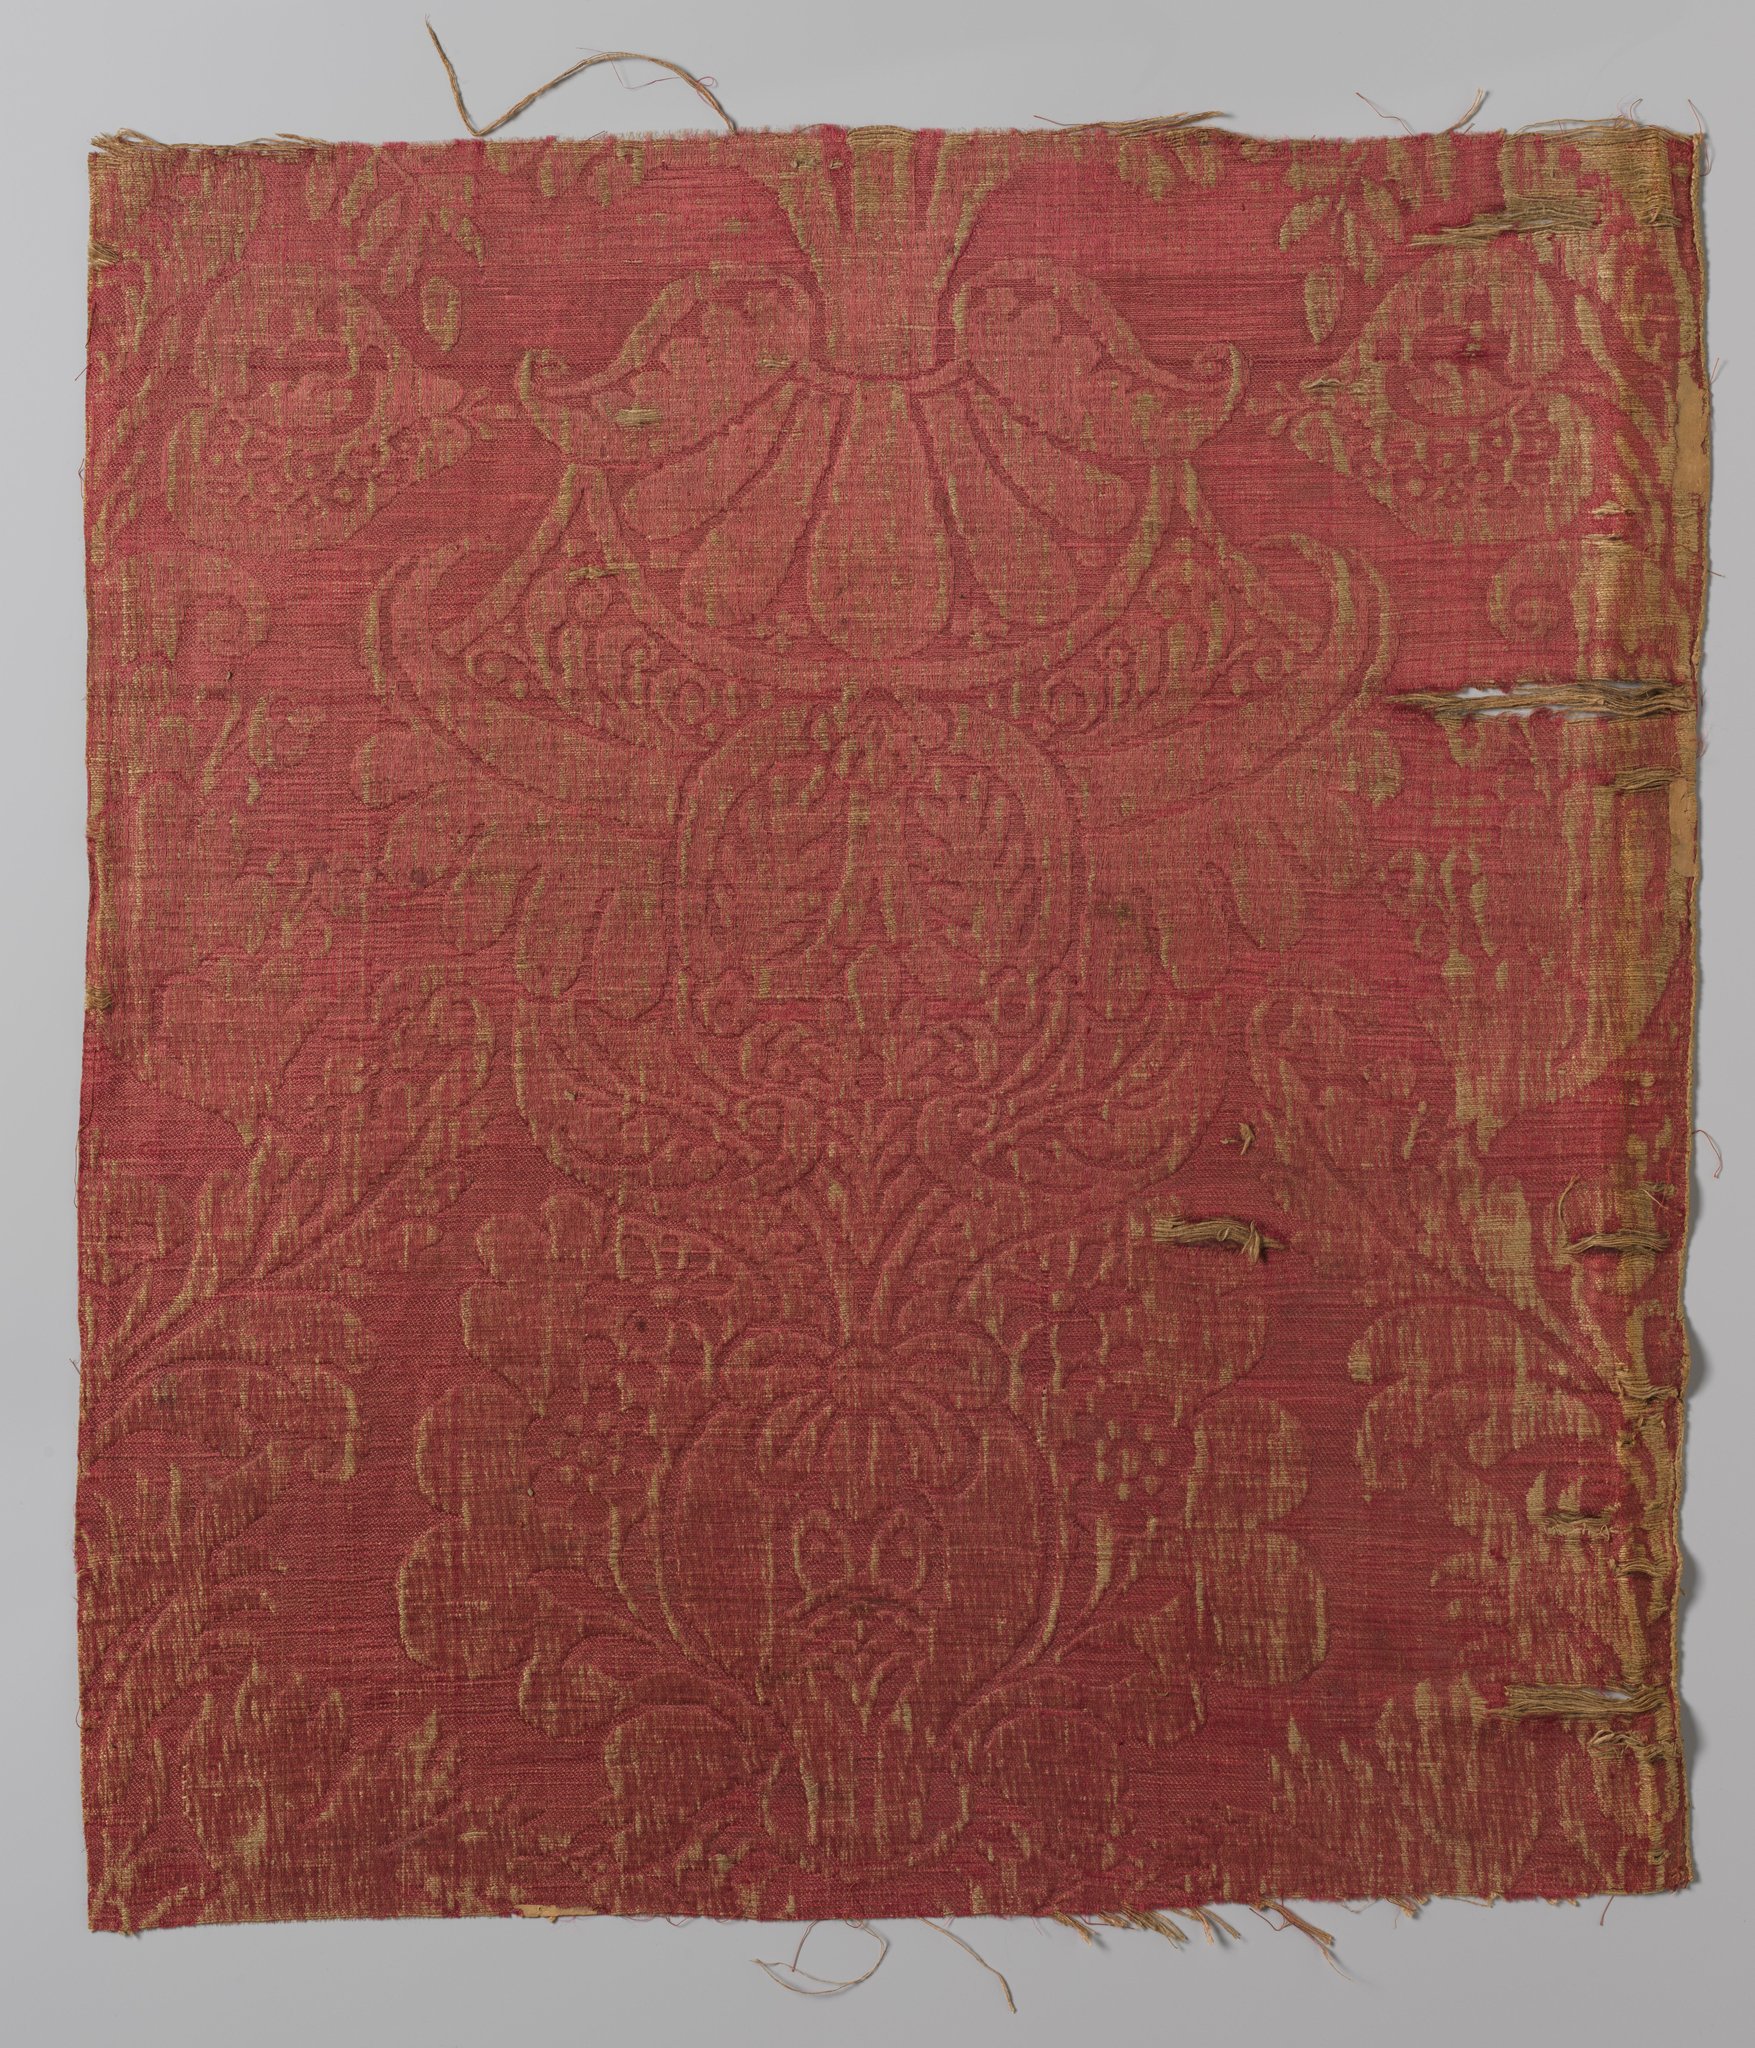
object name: fragment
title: Fragment van rode linnen en zijde, zogenaamde brokatel, met gestileerd bloemenfiguur met vaasvormige voet en omgeven door gestileerde bladeren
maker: Anonymous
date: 1700-1725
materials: textile, linen, silk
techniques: damask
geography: germany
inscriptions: label: ‘146’, label: ‘3641’, label: ‘Brokatel. Tweede helft der 17e eeuw. Cat. 146 Inv. 3641’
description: Fragment zogenaamde brokatel, rood met linnen schering en zijden inslag. Patroon van gestileerd bloemenfiguur met vaasvormige voet, omgeven door gesileerde bladeren.